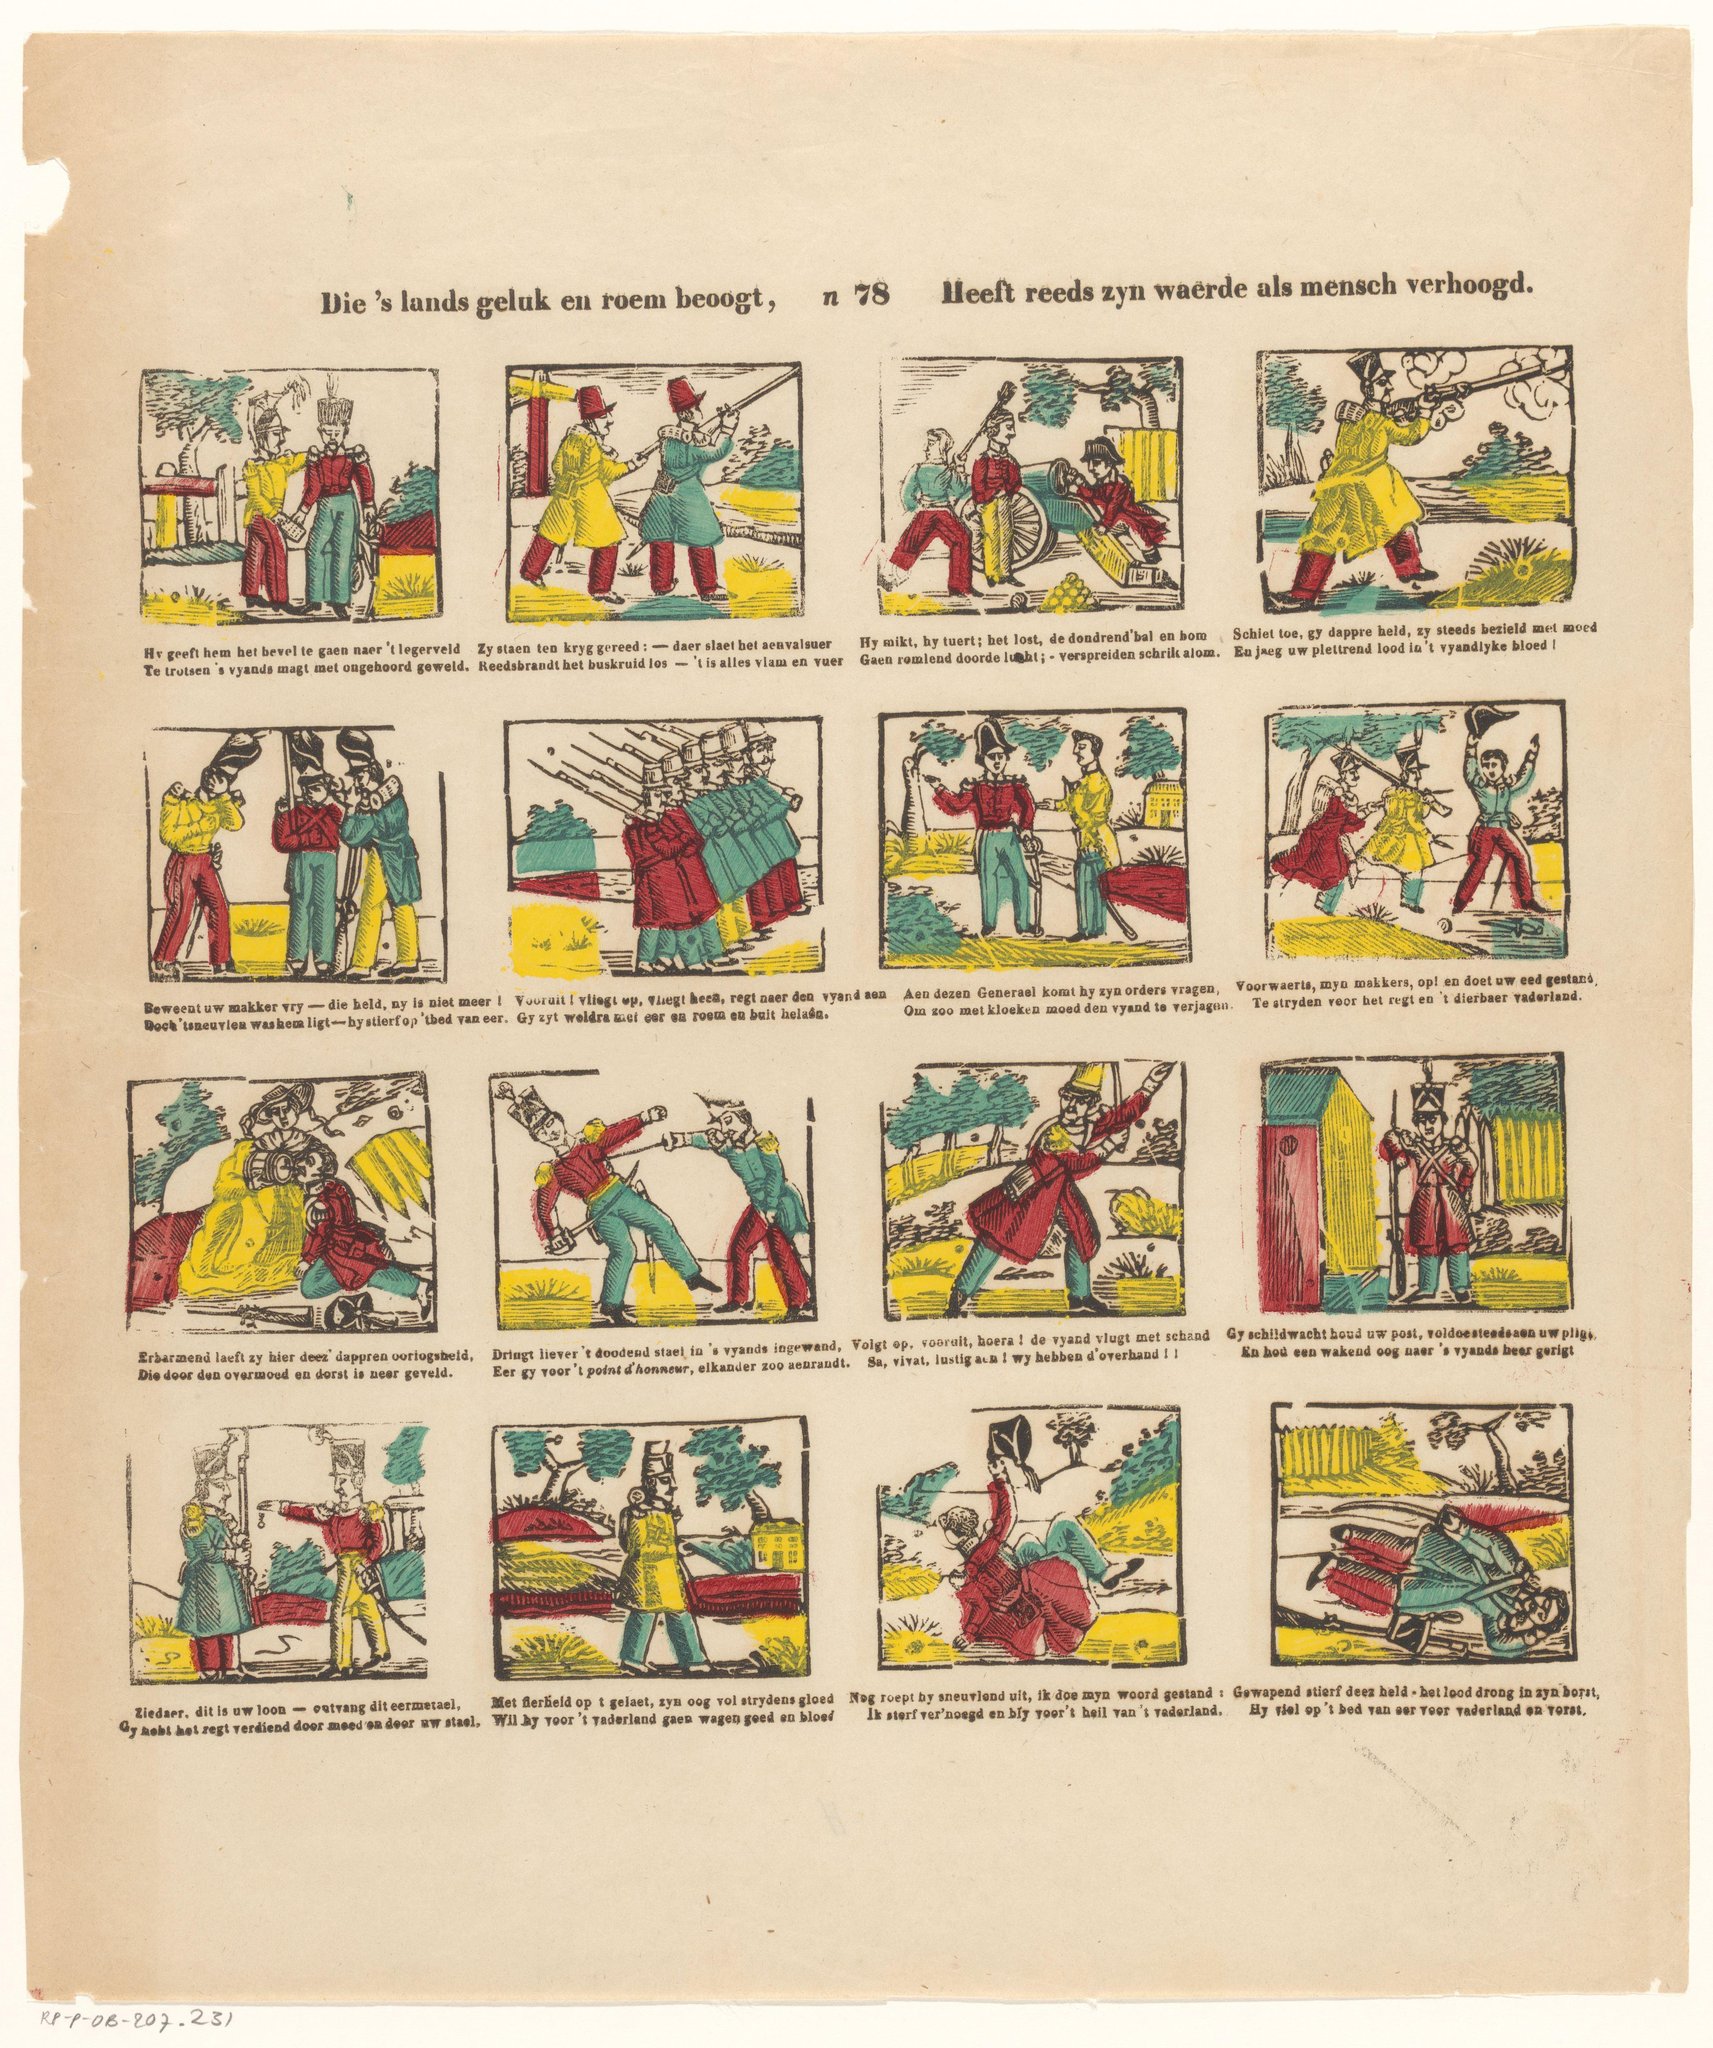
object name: print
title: Die 's lands geluk en roem beoogt, / Heeft reeds zyn waerde als mensch verhoogd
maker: Anonymous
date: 1856-1900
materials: paper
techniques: colour, letterpress printing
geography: netherlands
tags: the soldier; the soldier's life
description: Blad met 16 voorstellingen over het leven van militairen. Onder elke afbeelding een onderschrift. Genummerd midden boven: n 78.